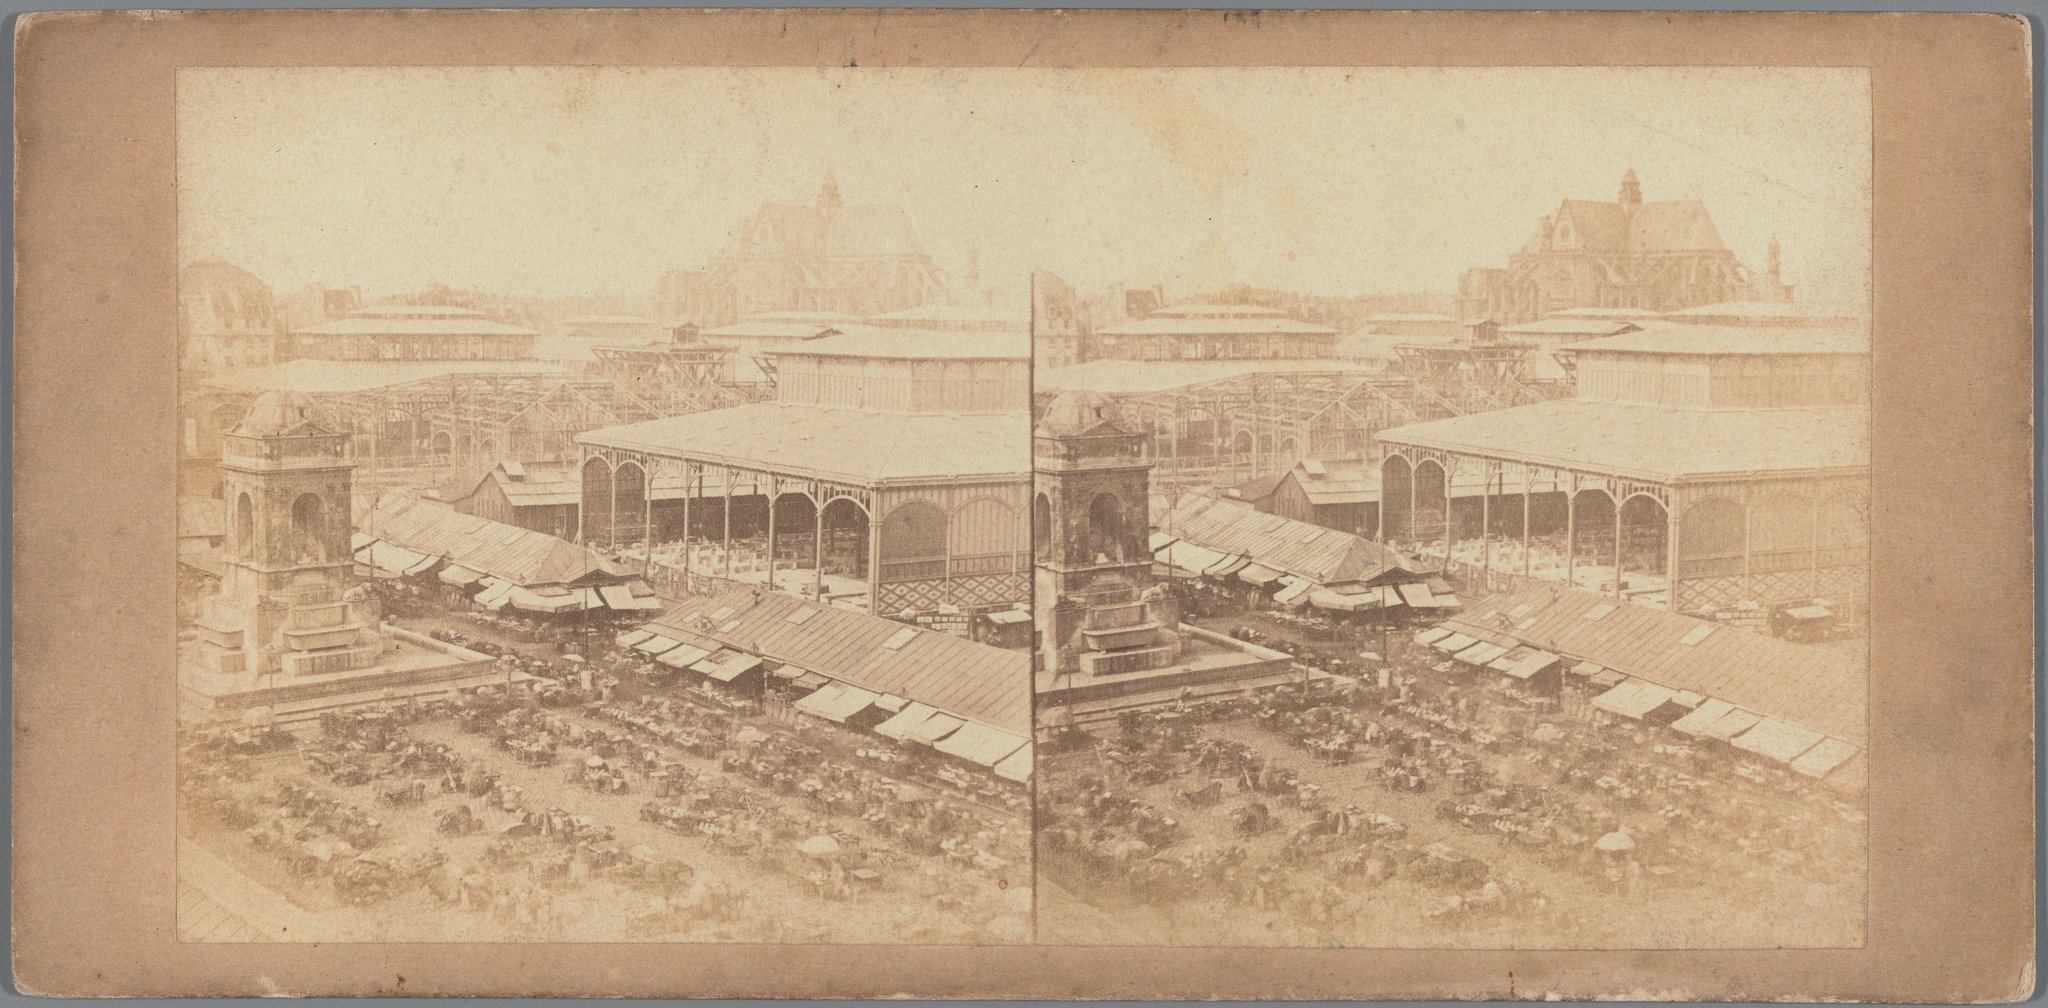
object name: stereograph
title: Gezicht op de markt Les Halles in Parijs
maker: Anonymous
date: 1860-1880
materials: cardboard, paper, photographic support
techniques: albumen print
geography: paris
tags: market, market-hall, paris